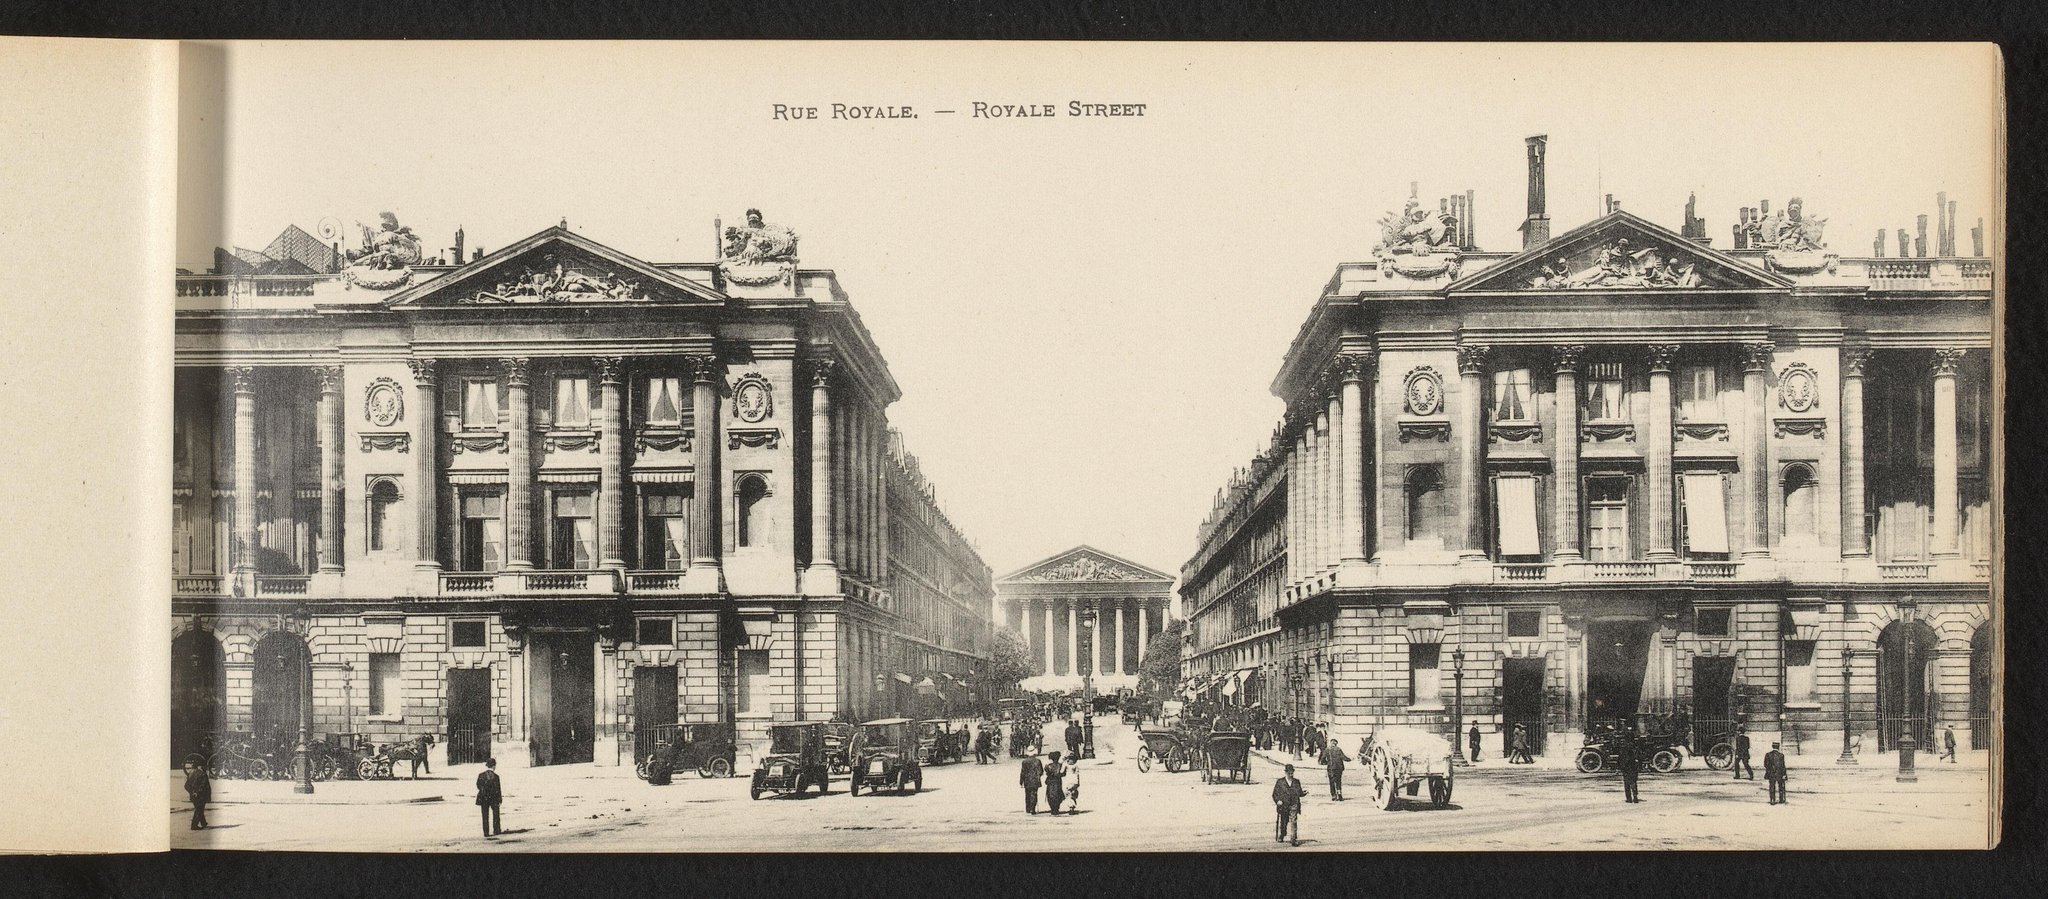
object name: photomechanical print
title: Rue Royale / Royale Street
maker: Anonymous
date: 1920-1932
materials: cardboard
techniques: photograph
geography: paris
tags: four-wheeled, animal-drawn vehicle, e.g.: cab, carriage, coach, city-view, and landscape with man-made constructions (+ city(-scape) with figures, staffage)